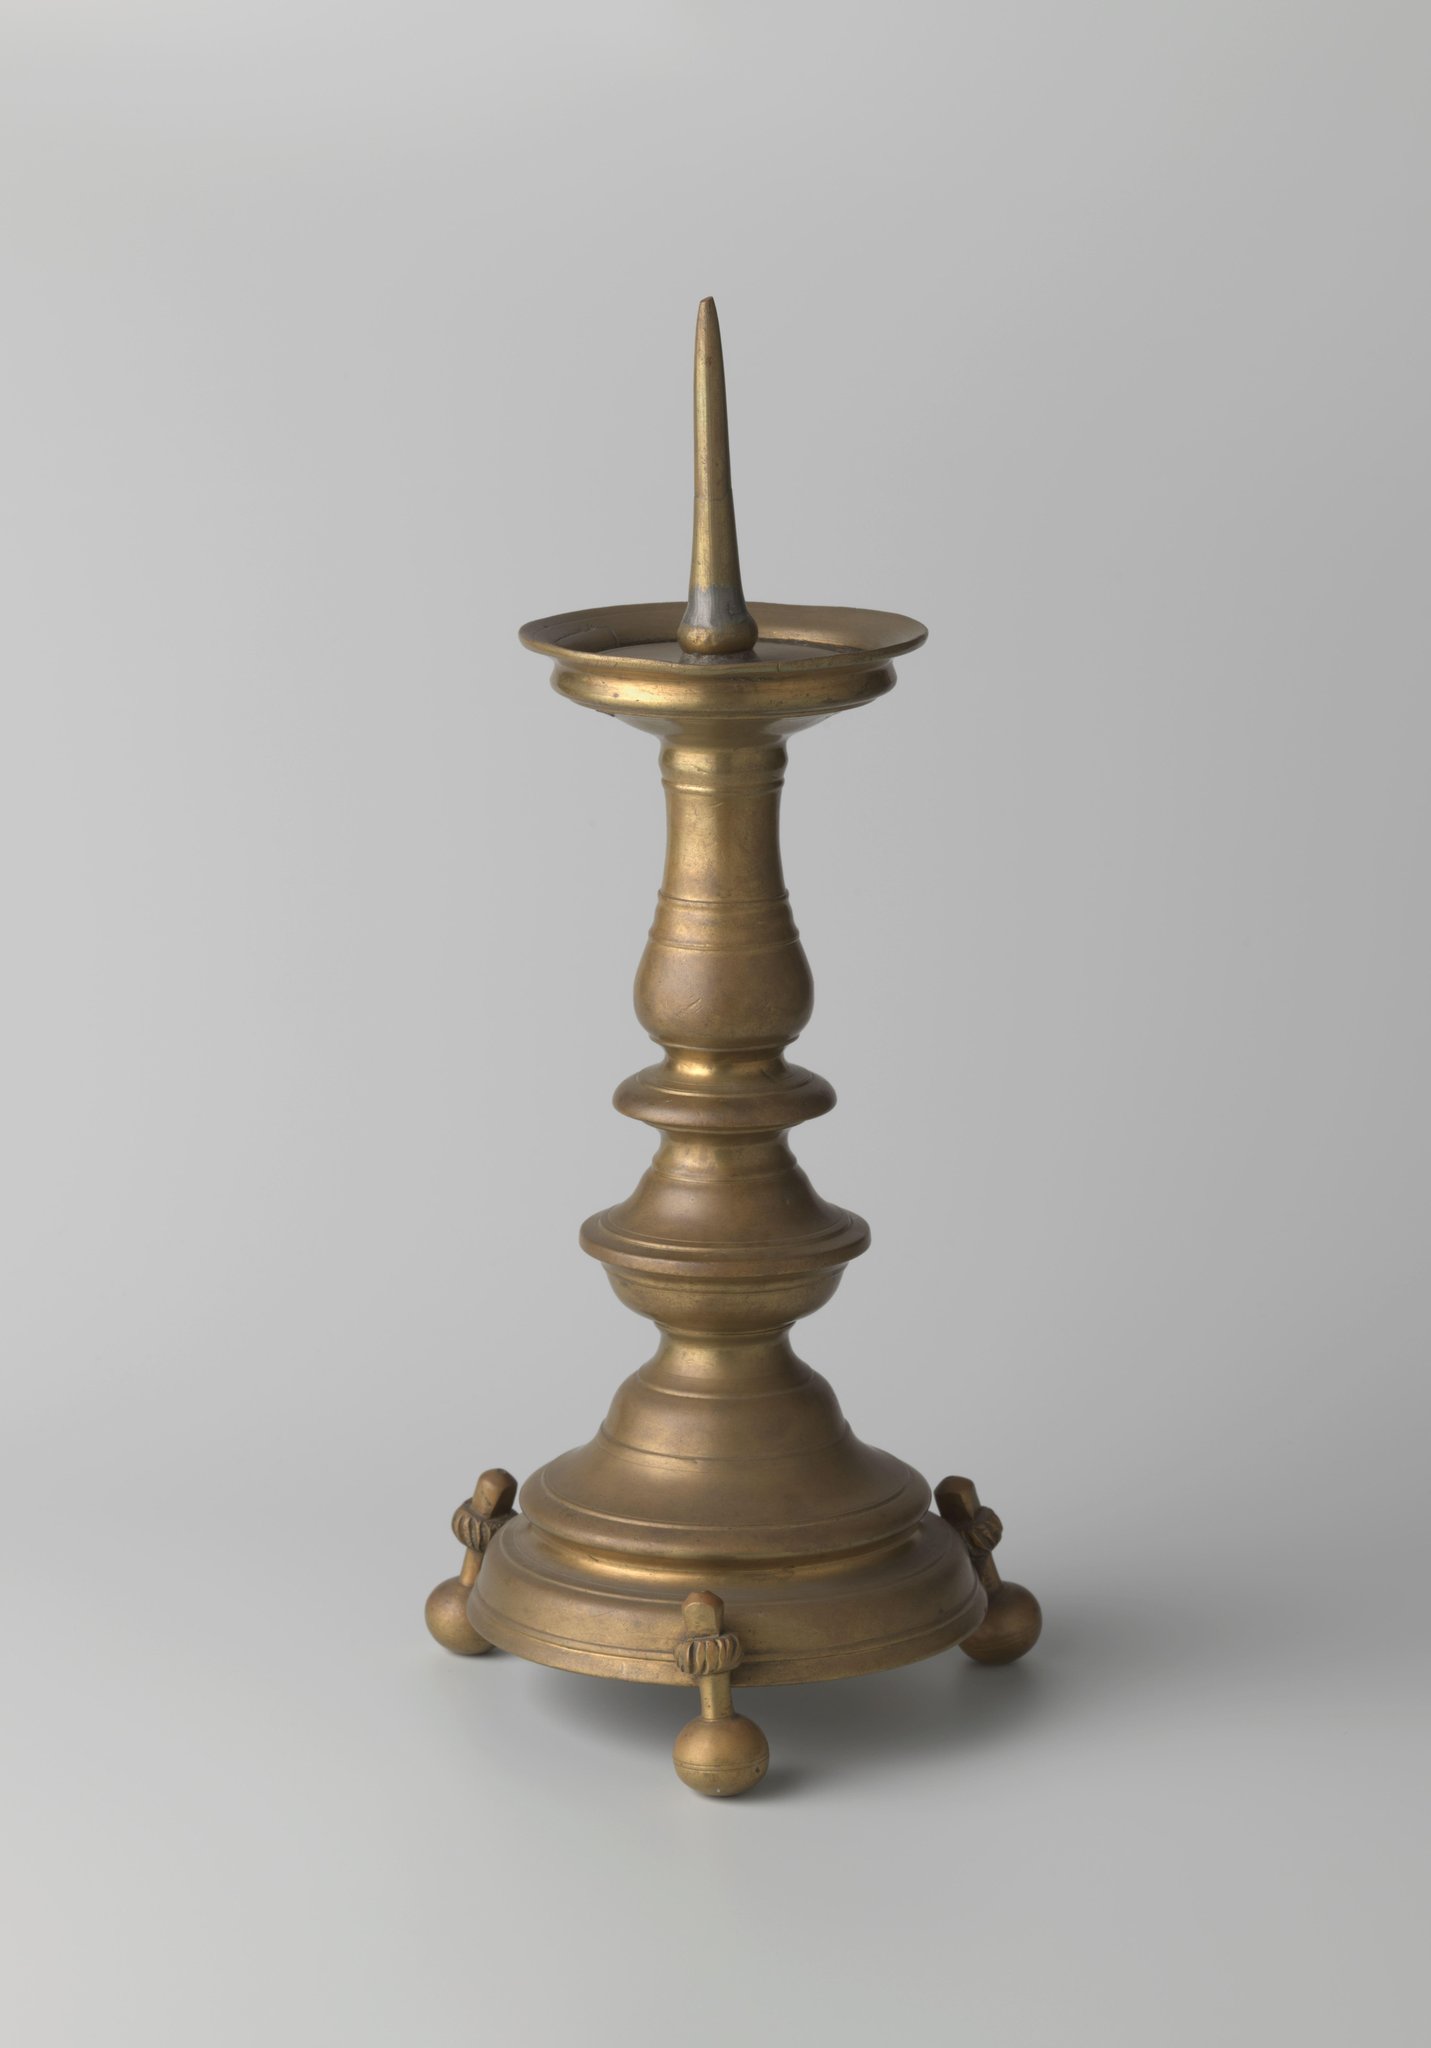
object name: candlestick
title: Kandelaar van messing op drie bolpoten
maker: Anonymous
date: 1575-1600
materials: brass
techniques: casting, riveted, turning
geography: southern netherlands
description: Voet, stam en vetvanger zijn uit één stuk gegoten. De drie poten, de kaarsenpin en de bodem van de vetvanger zijn daaraan vastgeklonken. De geprofileerde conische voet gaat over in een geprofileerde stam, welke de vorm heeft van een urn, een knoop en een baluster, en vervolgens in een geprofileerde vetvanger met schuin uitlopende rand. De balpoten, die evenals de overige onderdelen zijn voorzien van ringprofielen, hebben bovenaan versierde uitsteeksels, waarmee zij aan de buitenkant van de voet zijn geklonken. De rand van de voet is aan de binnenkant afgedraaid. De pin is hersteld. De vetvanger is hersteld op één plaats door de gieter, die het voorwerp heeft gemaakt.